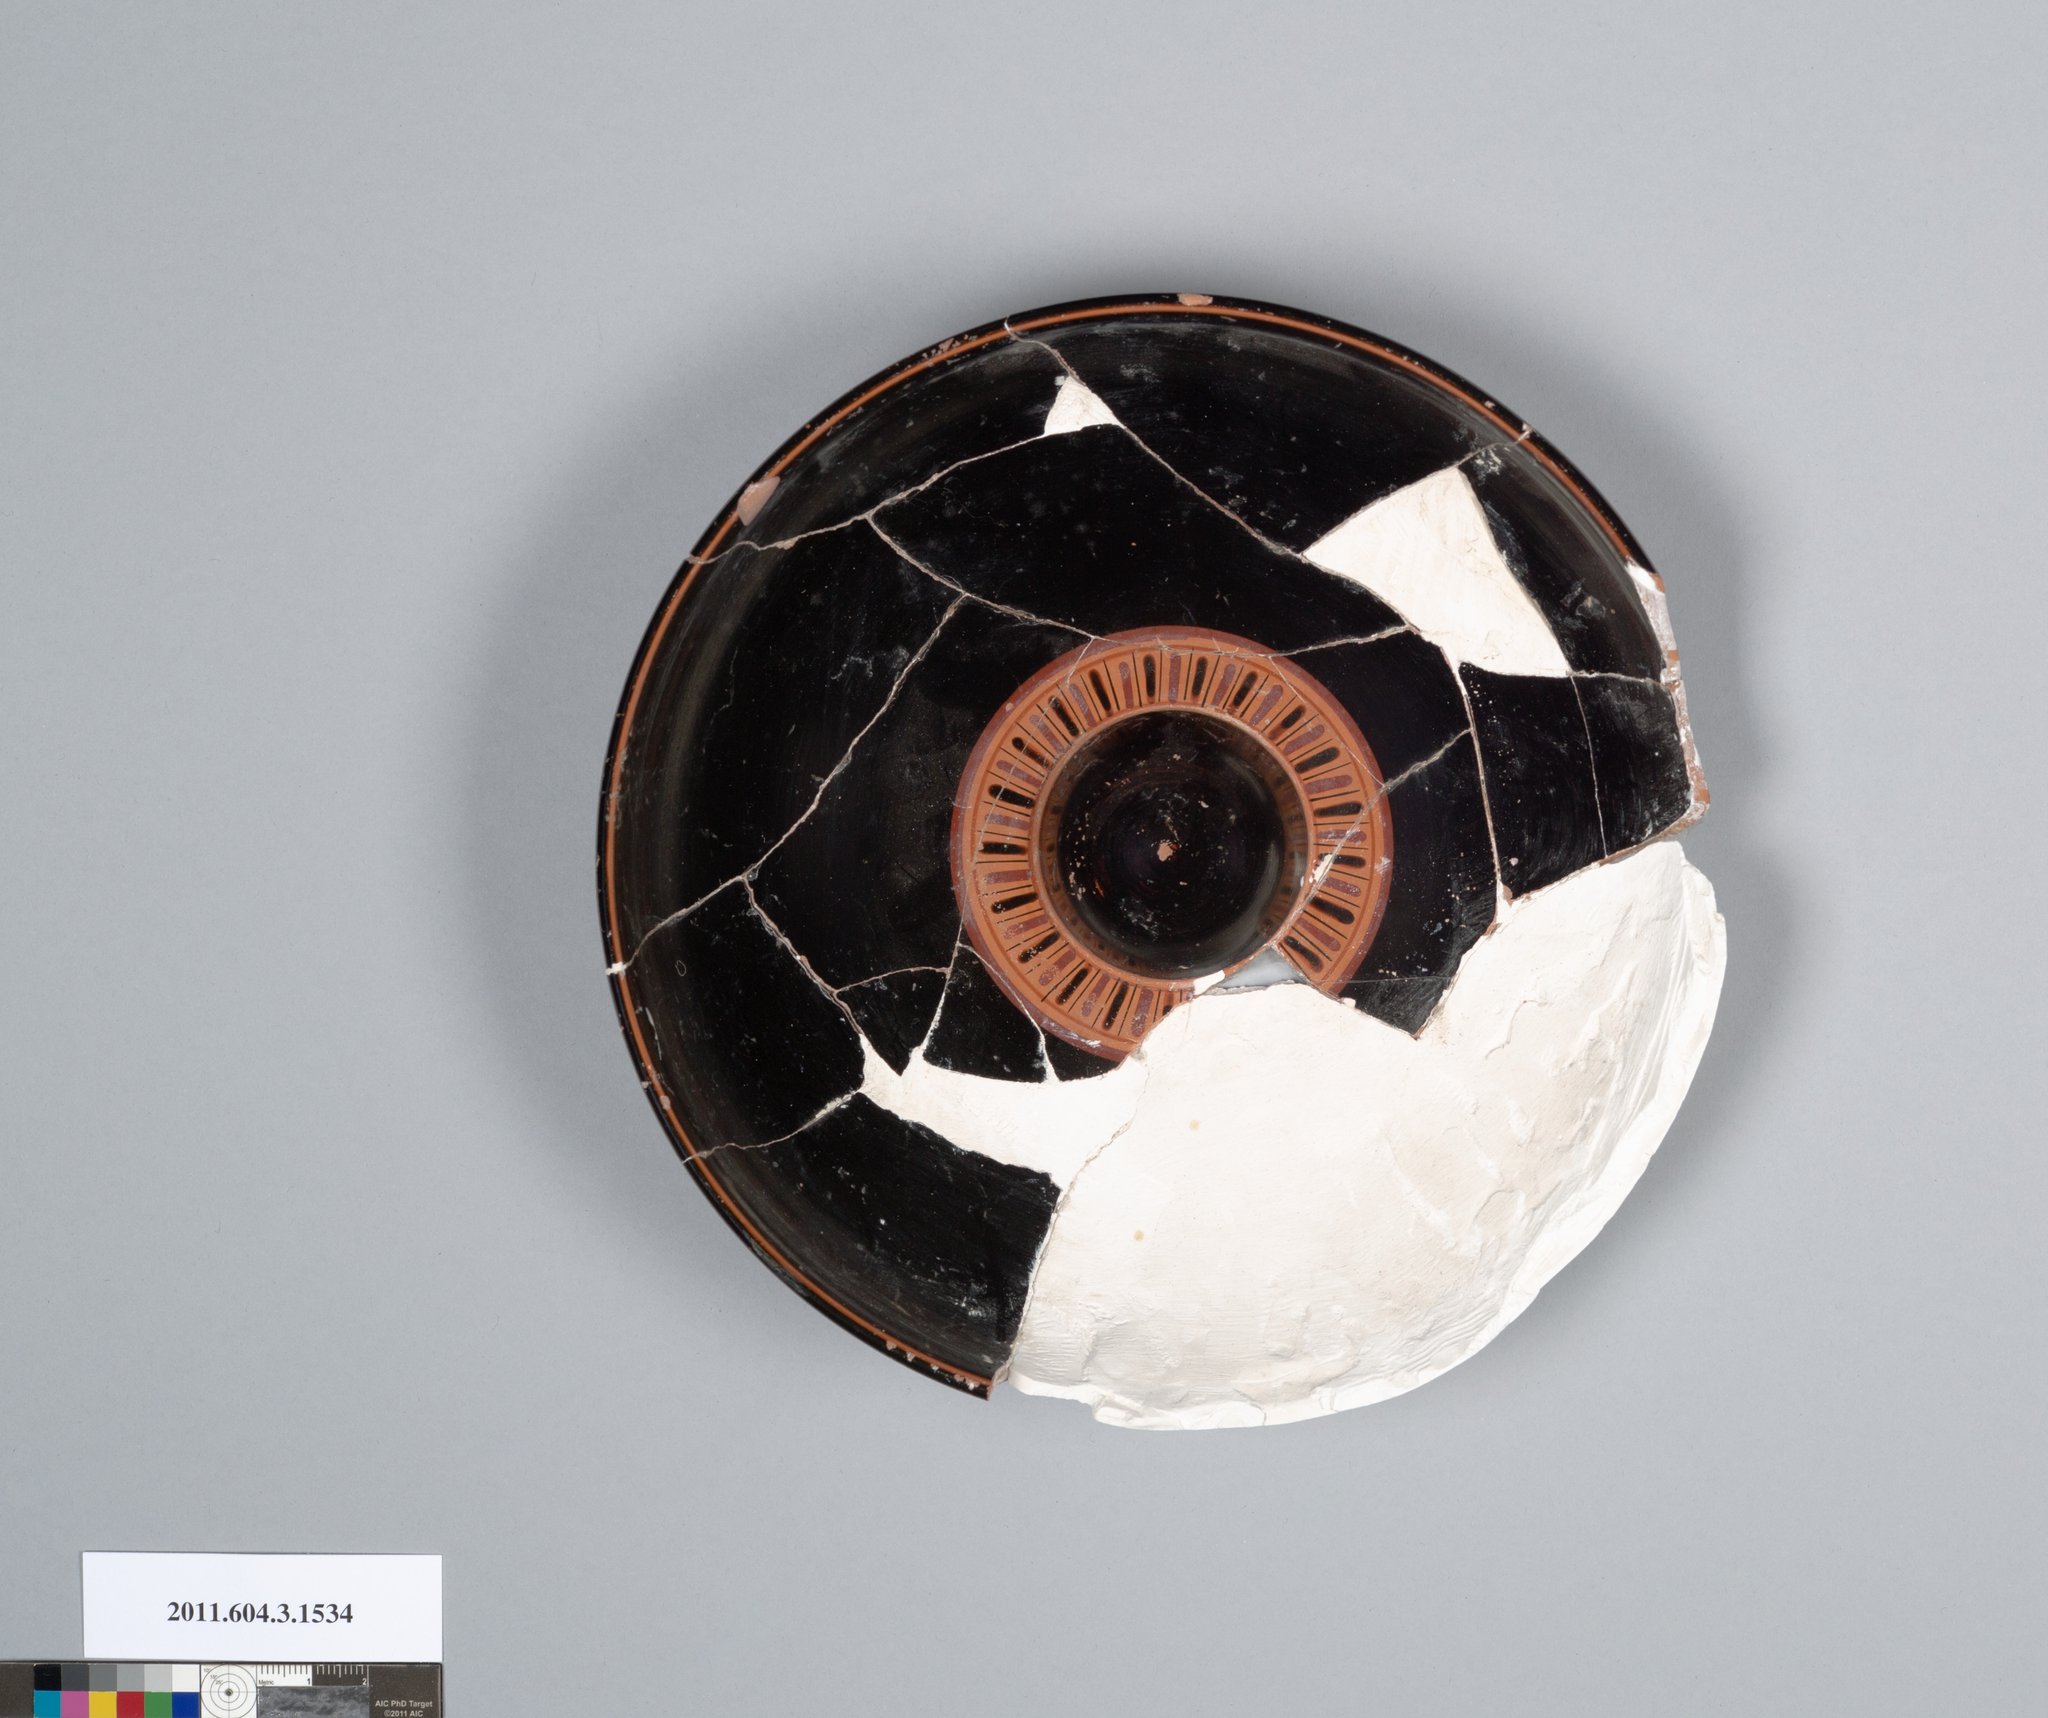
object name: phiale fragment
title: Terracotta fragment of a phiale (libation bowl)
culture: greek, attic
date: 550-526 BCE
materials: terracotta